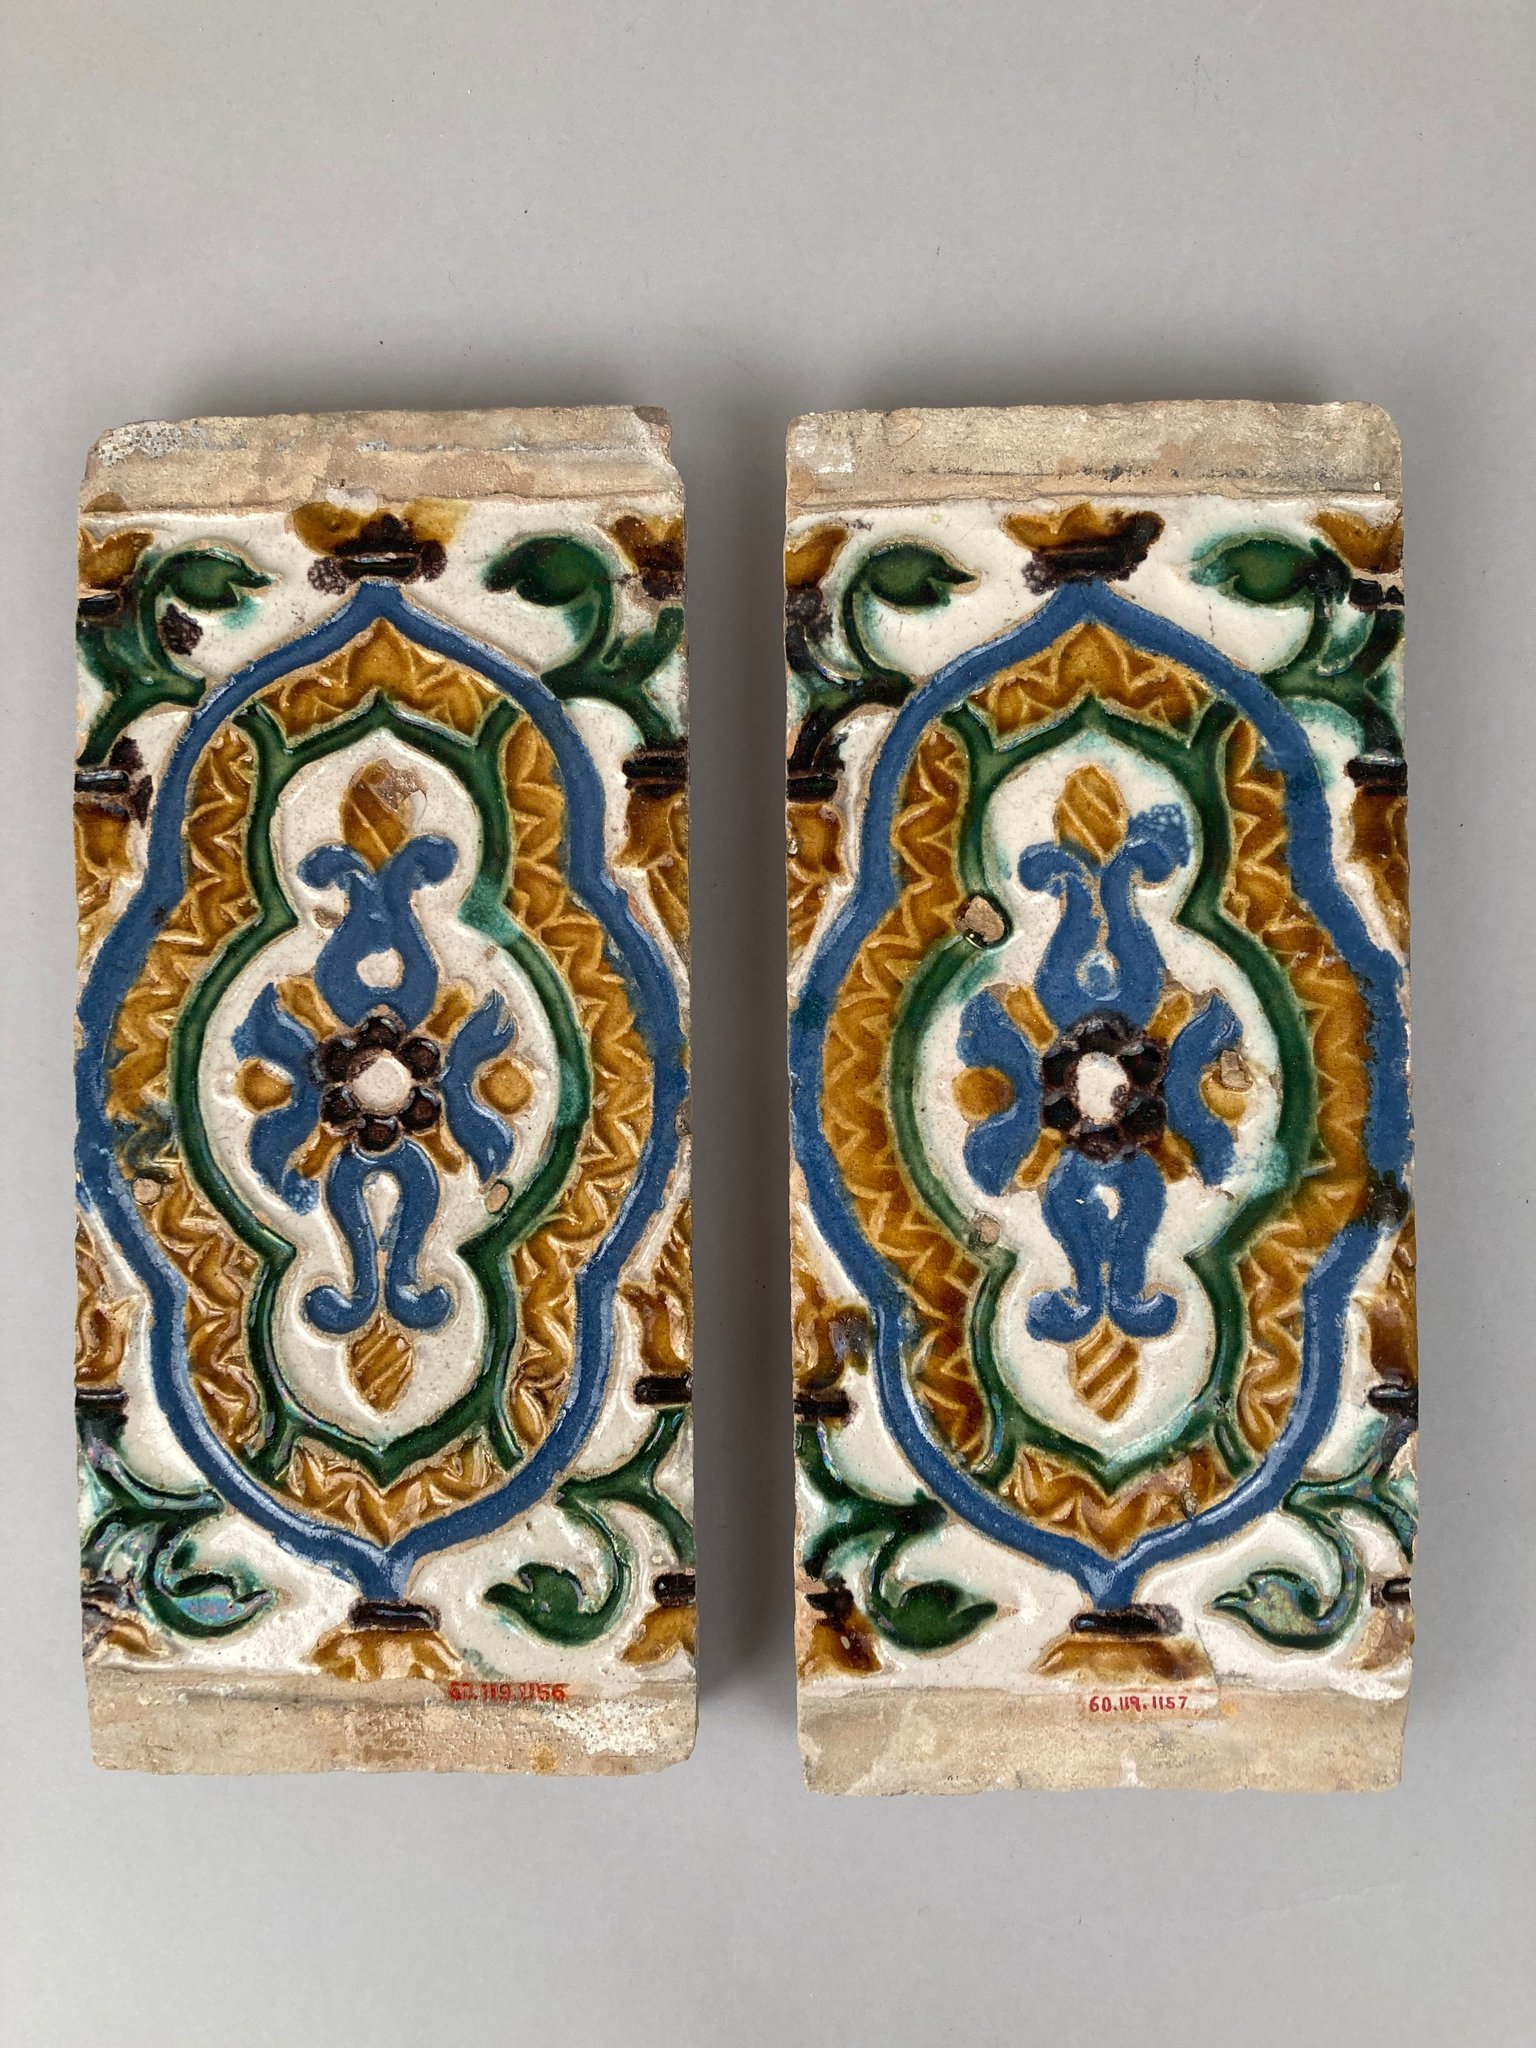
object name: ceiling tile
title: Ceiling tiles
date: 1534-1566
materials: earthenware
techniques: glazing